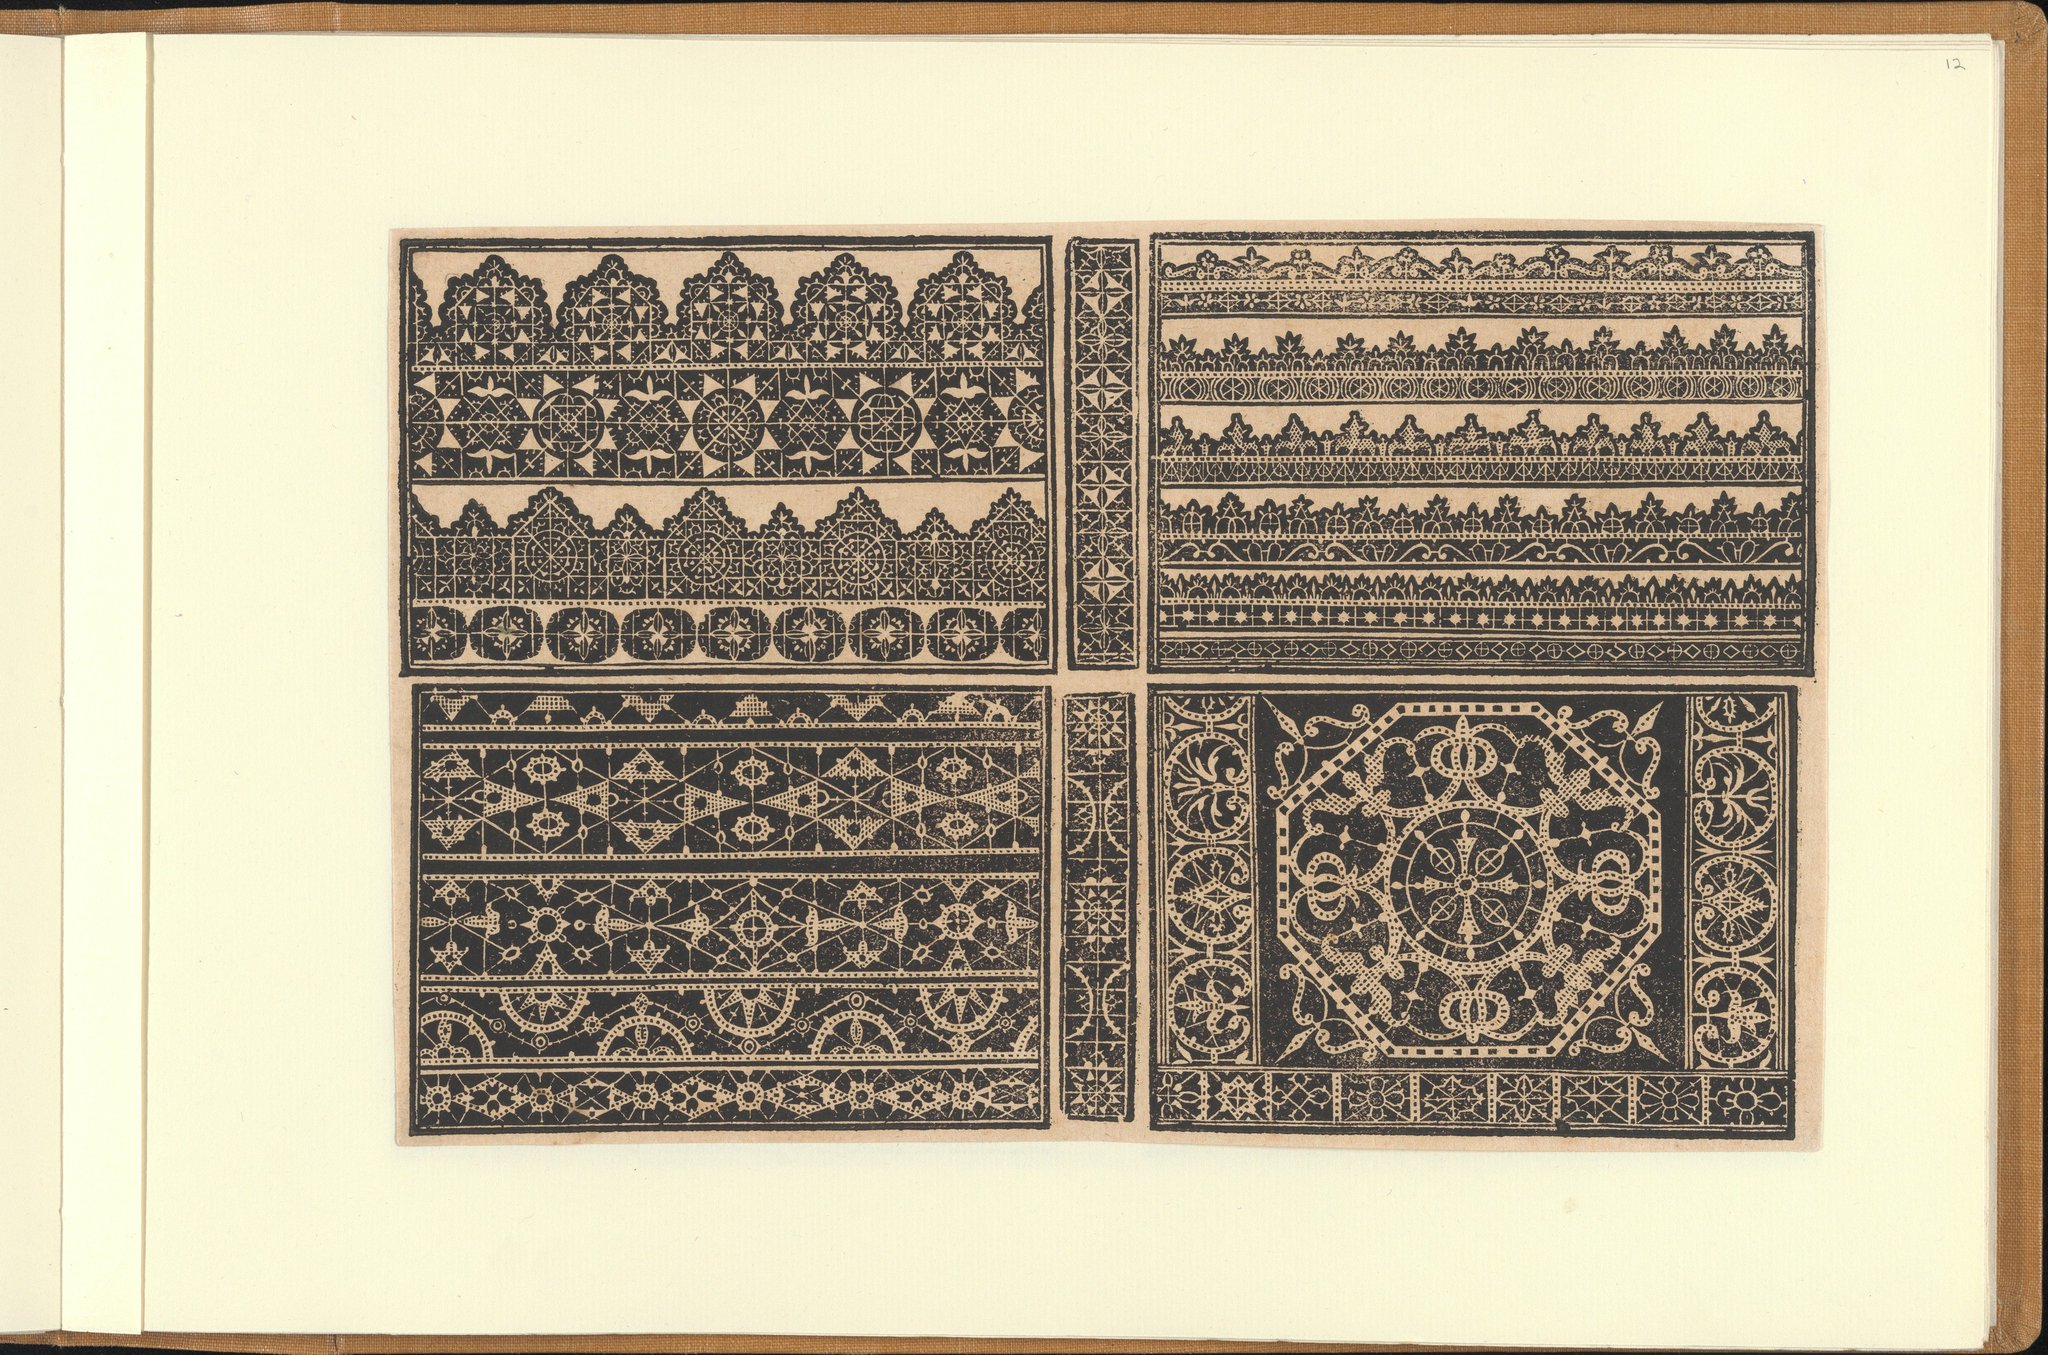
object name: album print ornament architecture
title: Schon newes Modelbuch...Page 12(r)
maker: sigismundus latomus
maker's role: designer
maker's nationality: german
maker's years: 1599-1632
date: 1617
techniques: woodcut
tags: ornament